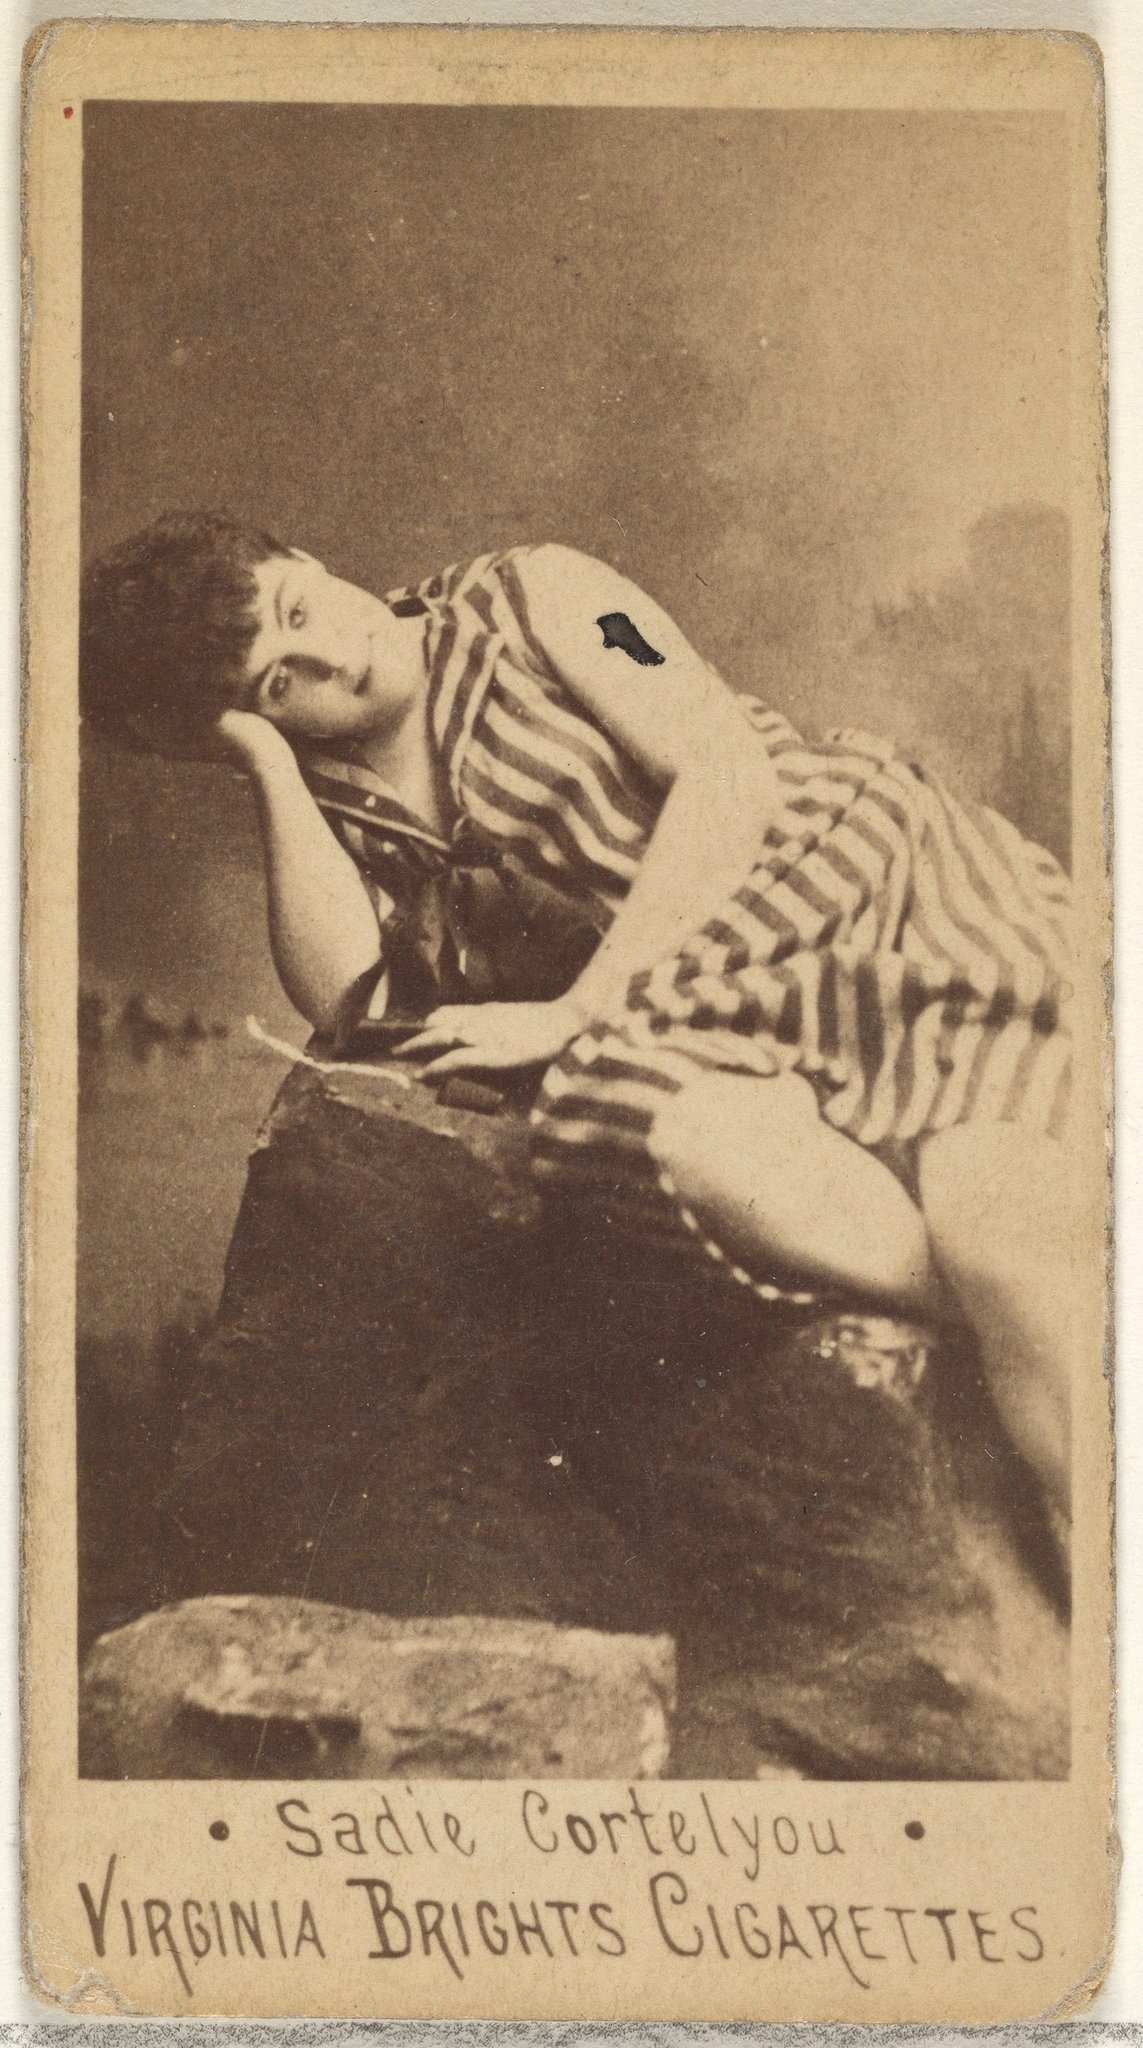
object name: photograph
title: Sadie Cortelyou, from the Actors and Actresses series (N45, Type 1) for Virginia Brights Cigarettes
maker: allen & ginter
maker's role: publisher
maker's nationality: american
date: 1888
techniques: albumen silver print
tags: portraits,women,actresses